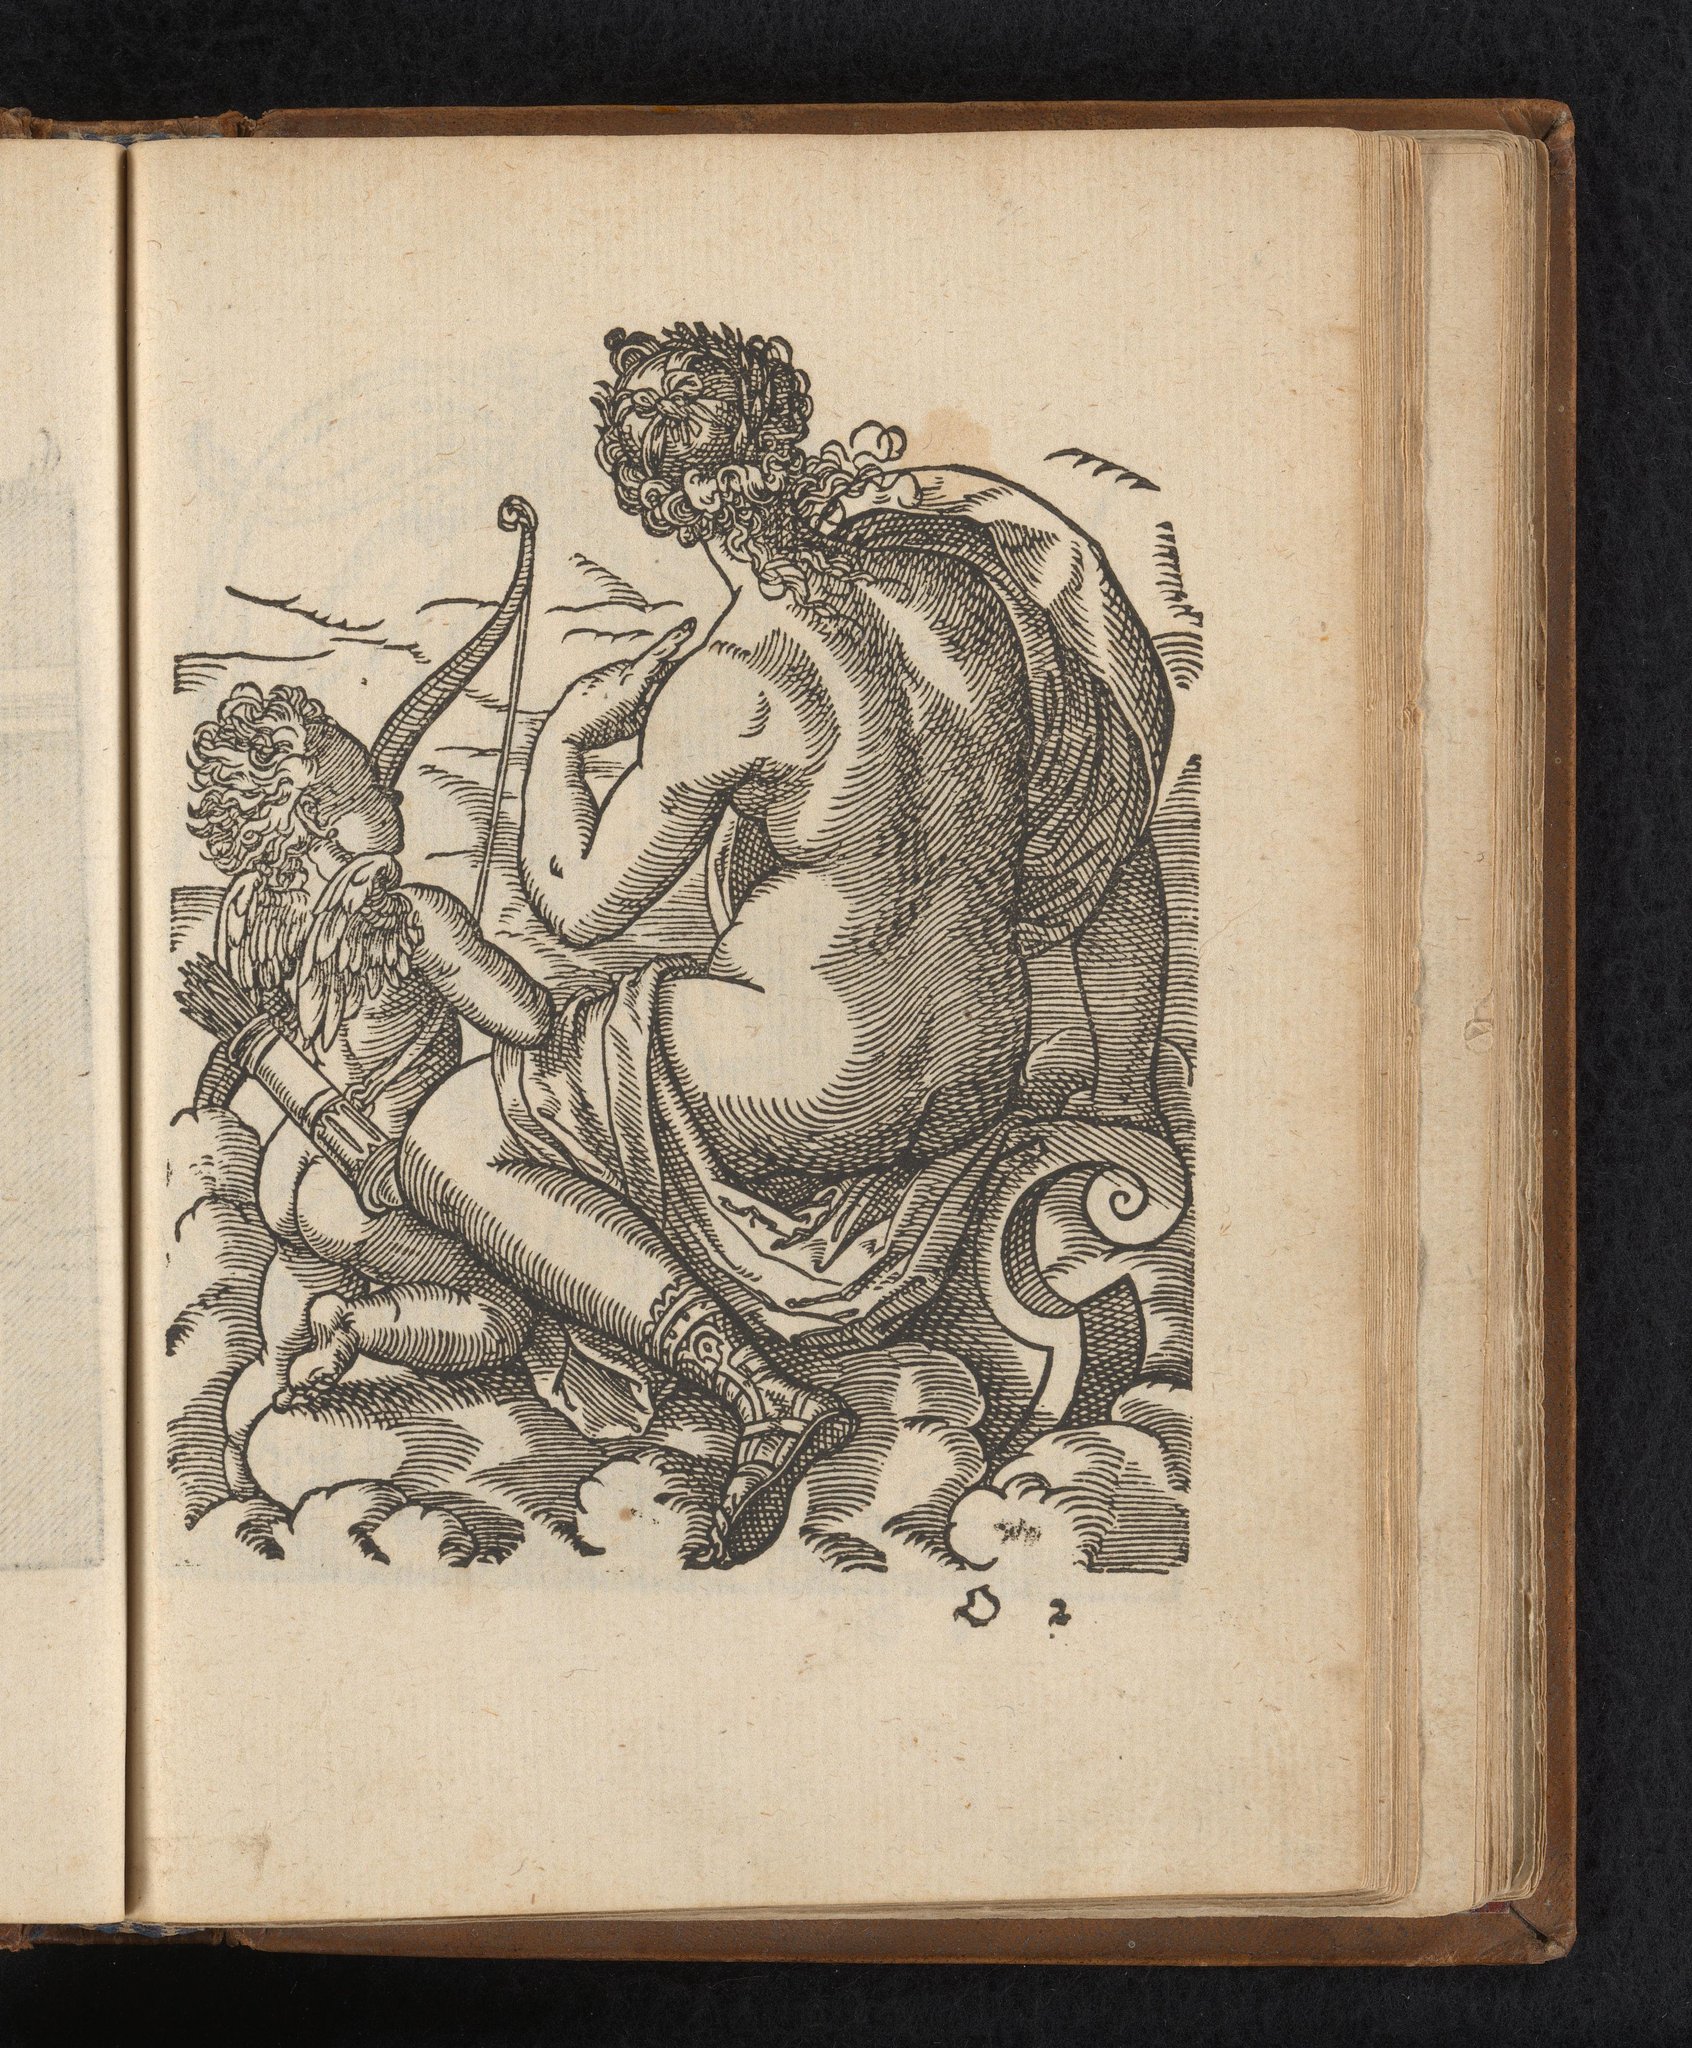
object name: print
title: Venus en Cupido in de wolken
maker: Anonymous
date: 1578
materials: paper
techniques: woodcut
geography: nuremberg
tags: venus and cupid (cupid not being mere attribute)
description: Venus en Cupido in de wolken, beiden op de rug gezien. Onderdeel van het modelboek Enchiridion artis pingendi, fingendi & sculpendi met 108 figuren bedoeld voor beginnende schilders, beeldhouwers en prentmakers.